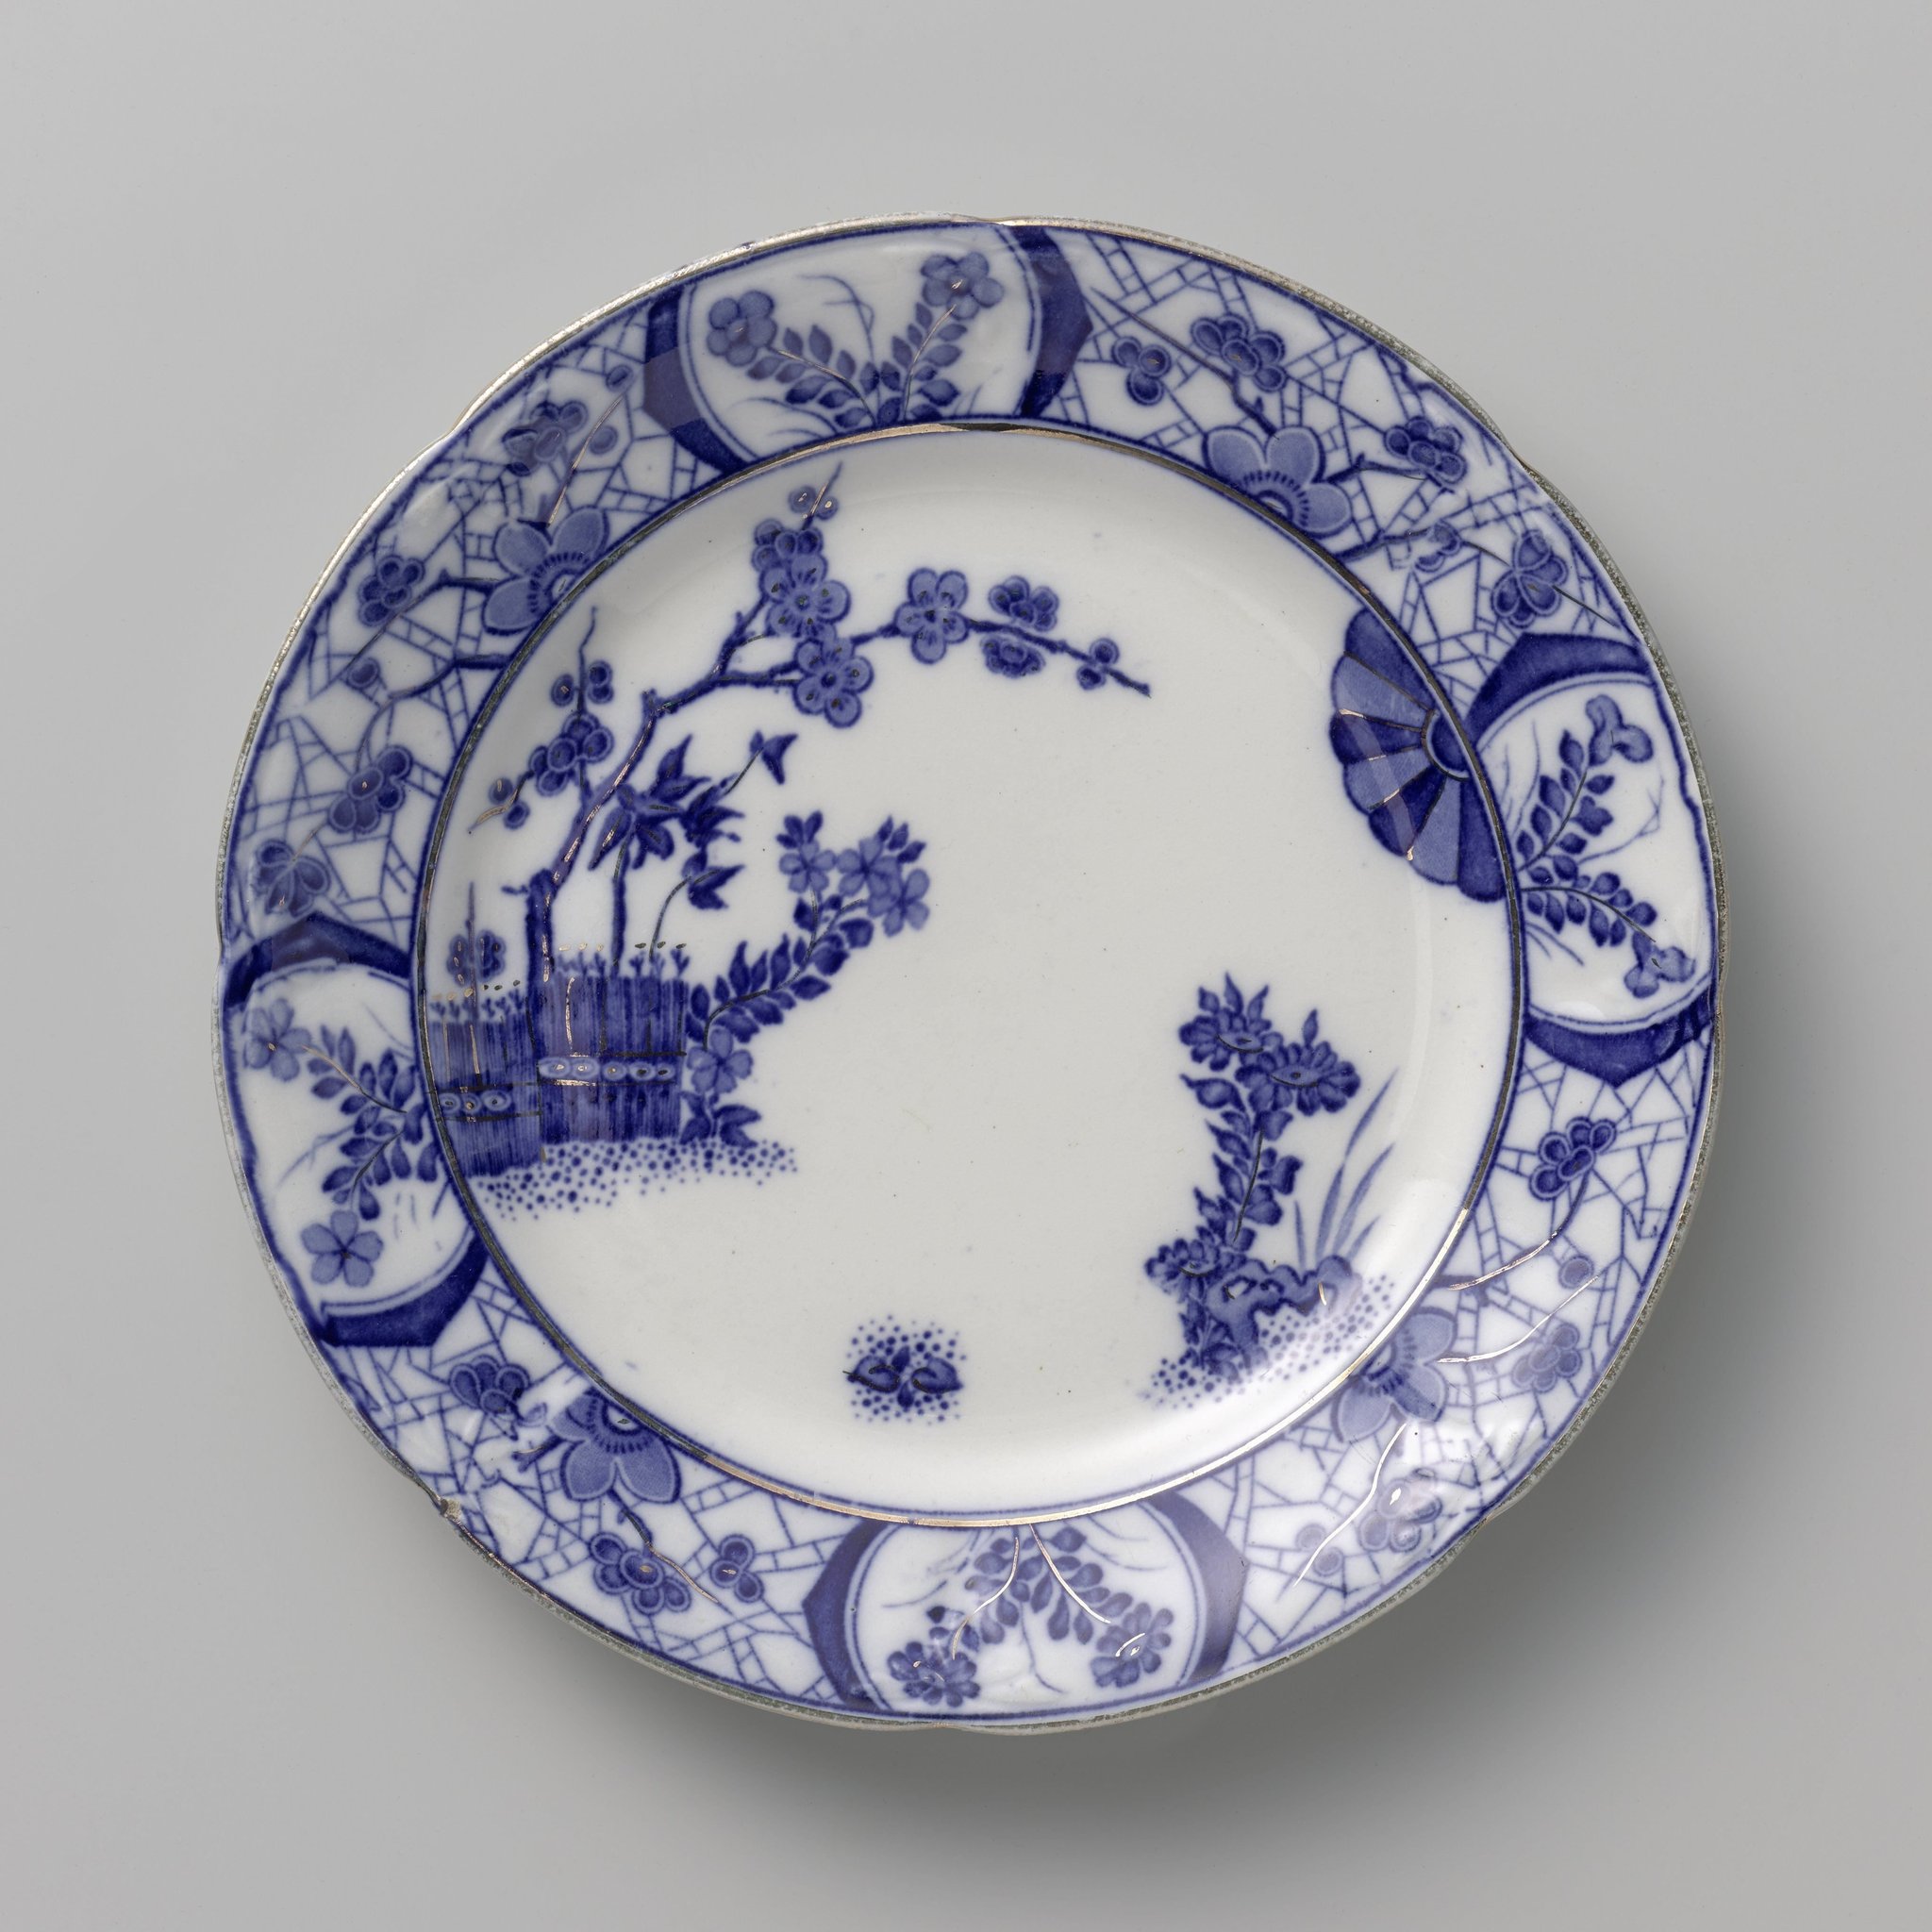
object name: plate dish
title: Bord met op het plat een prunusboom achter een rieten schutting en losse planten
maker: petrus regout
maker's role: plateelbakker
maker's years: 1801-1879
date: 1801-1879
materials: earthenware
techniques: hogen, transfer decoration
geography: maastricht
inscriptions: check stamp: ‘Y 7 1/2’, mark: ‘sfinx // PETRUS REGOUT // MAASTRICHT // NANKIN // MADE IN HOLLAND’, mark: ‘31’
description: Bord van aardewerk met vloeiblauw transferdecor, gehoogd met goud. Op het plat een prunusboom achter een rieten schutting en losse planten. De rand van het bord onder andere met gouden filets en vier cartouches met bloeiende takken.